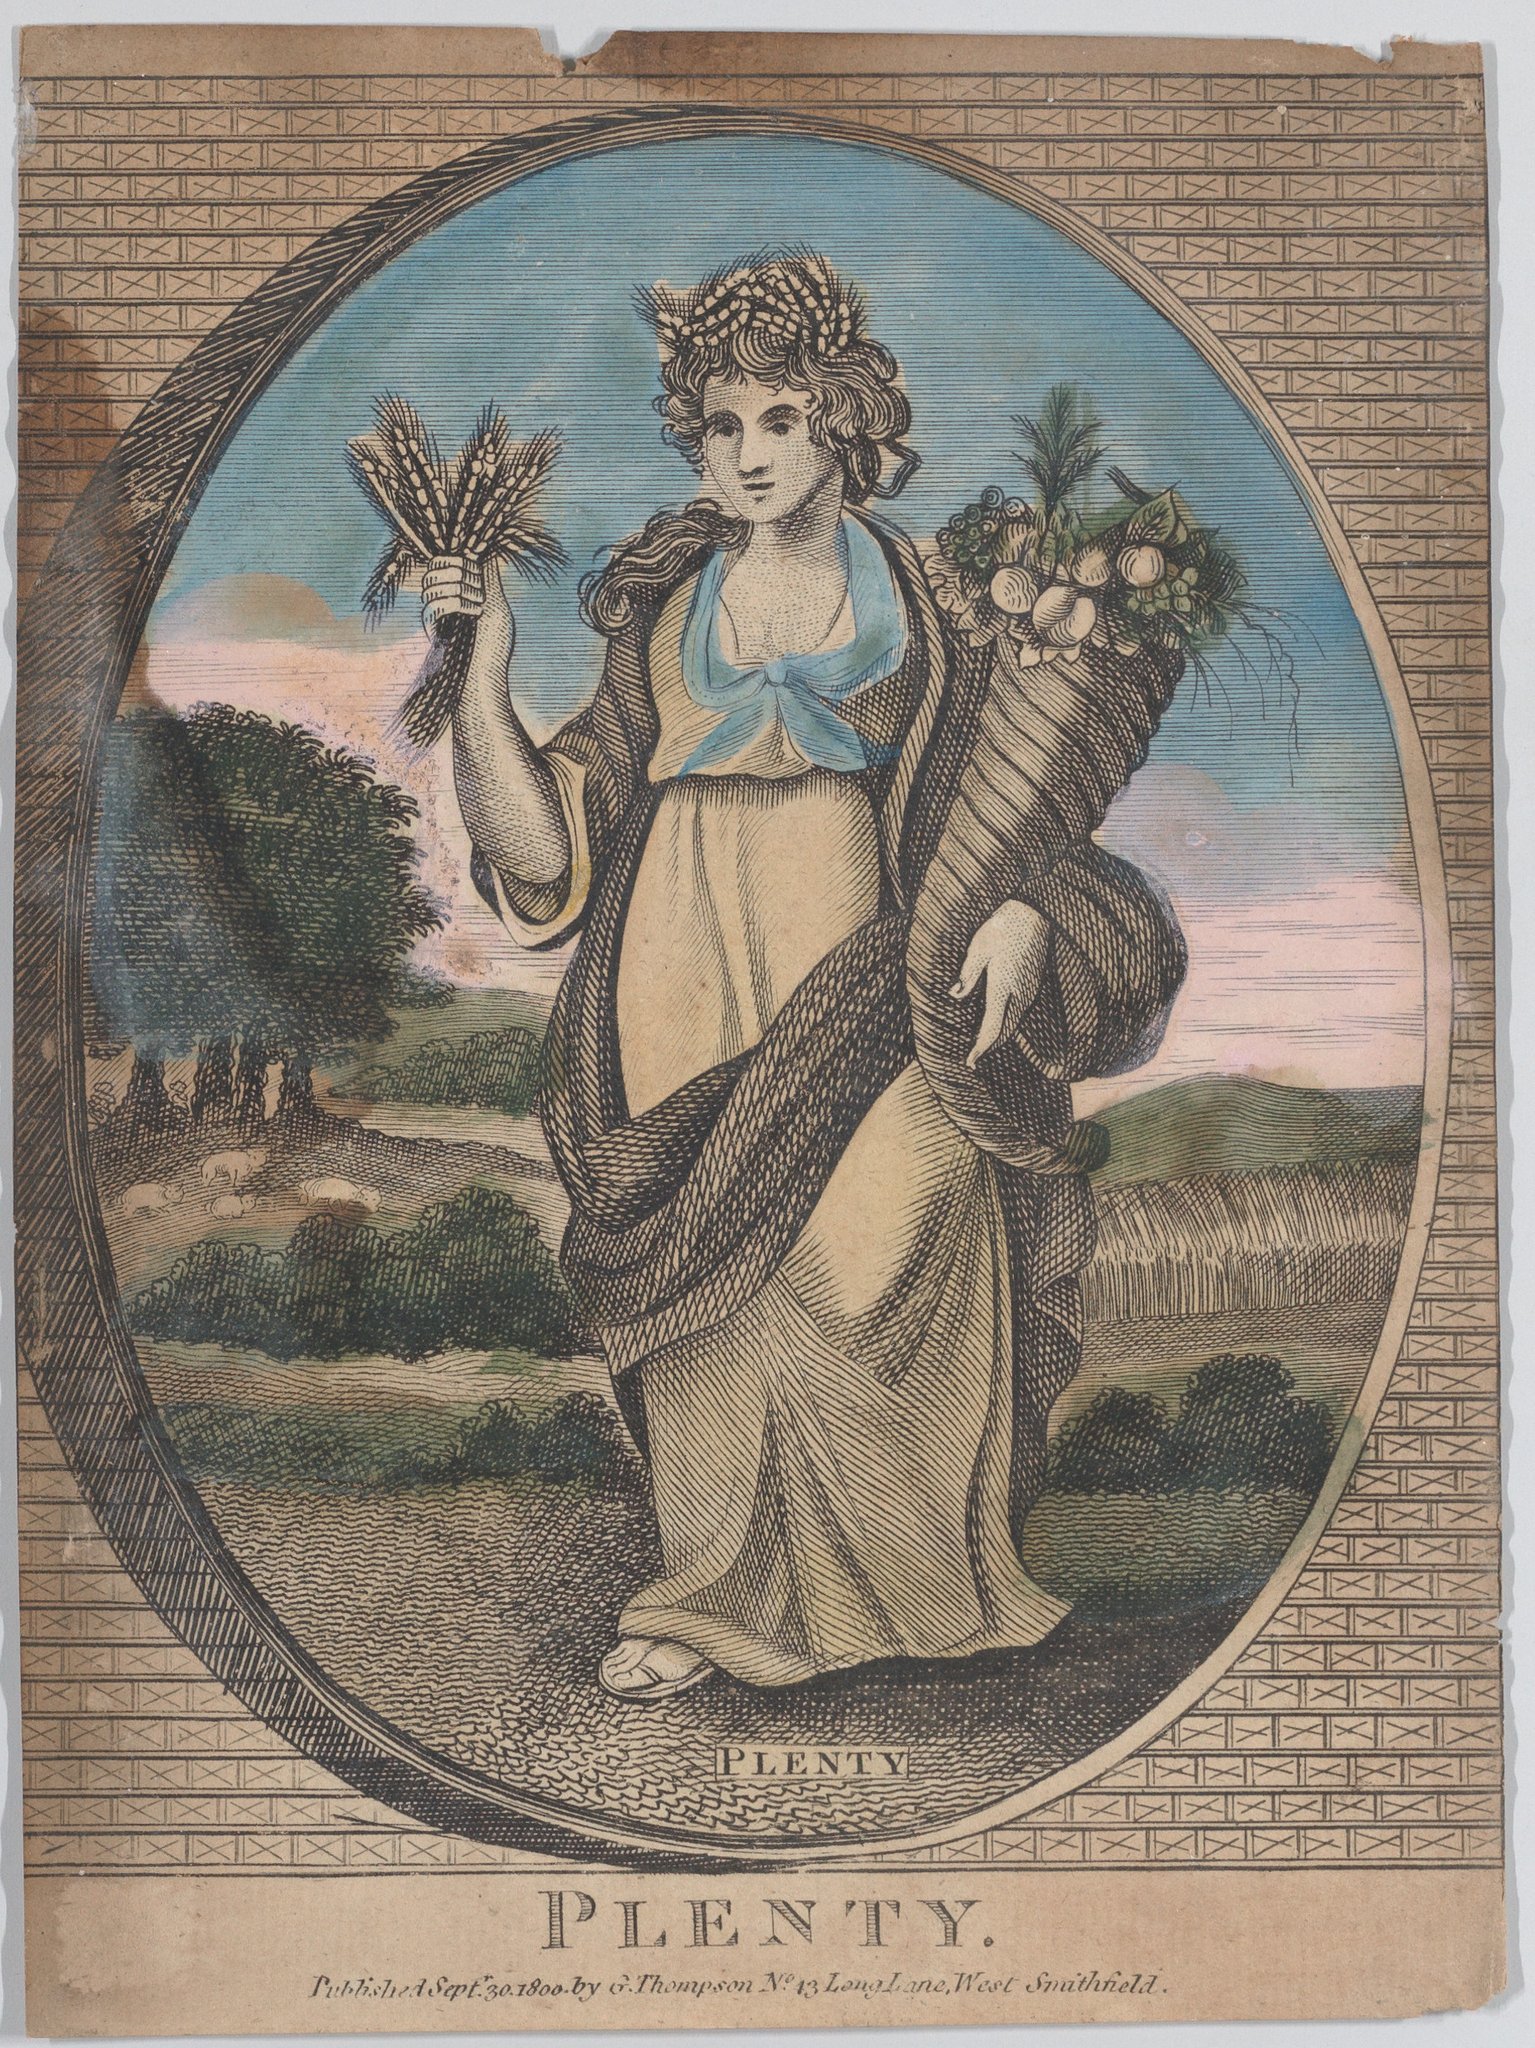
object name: print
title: Plenty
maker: anonymous, british, 19th century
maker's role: artist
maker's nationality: british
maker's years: 1800-1900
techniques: etching, hand coloring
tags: women,cornucopia